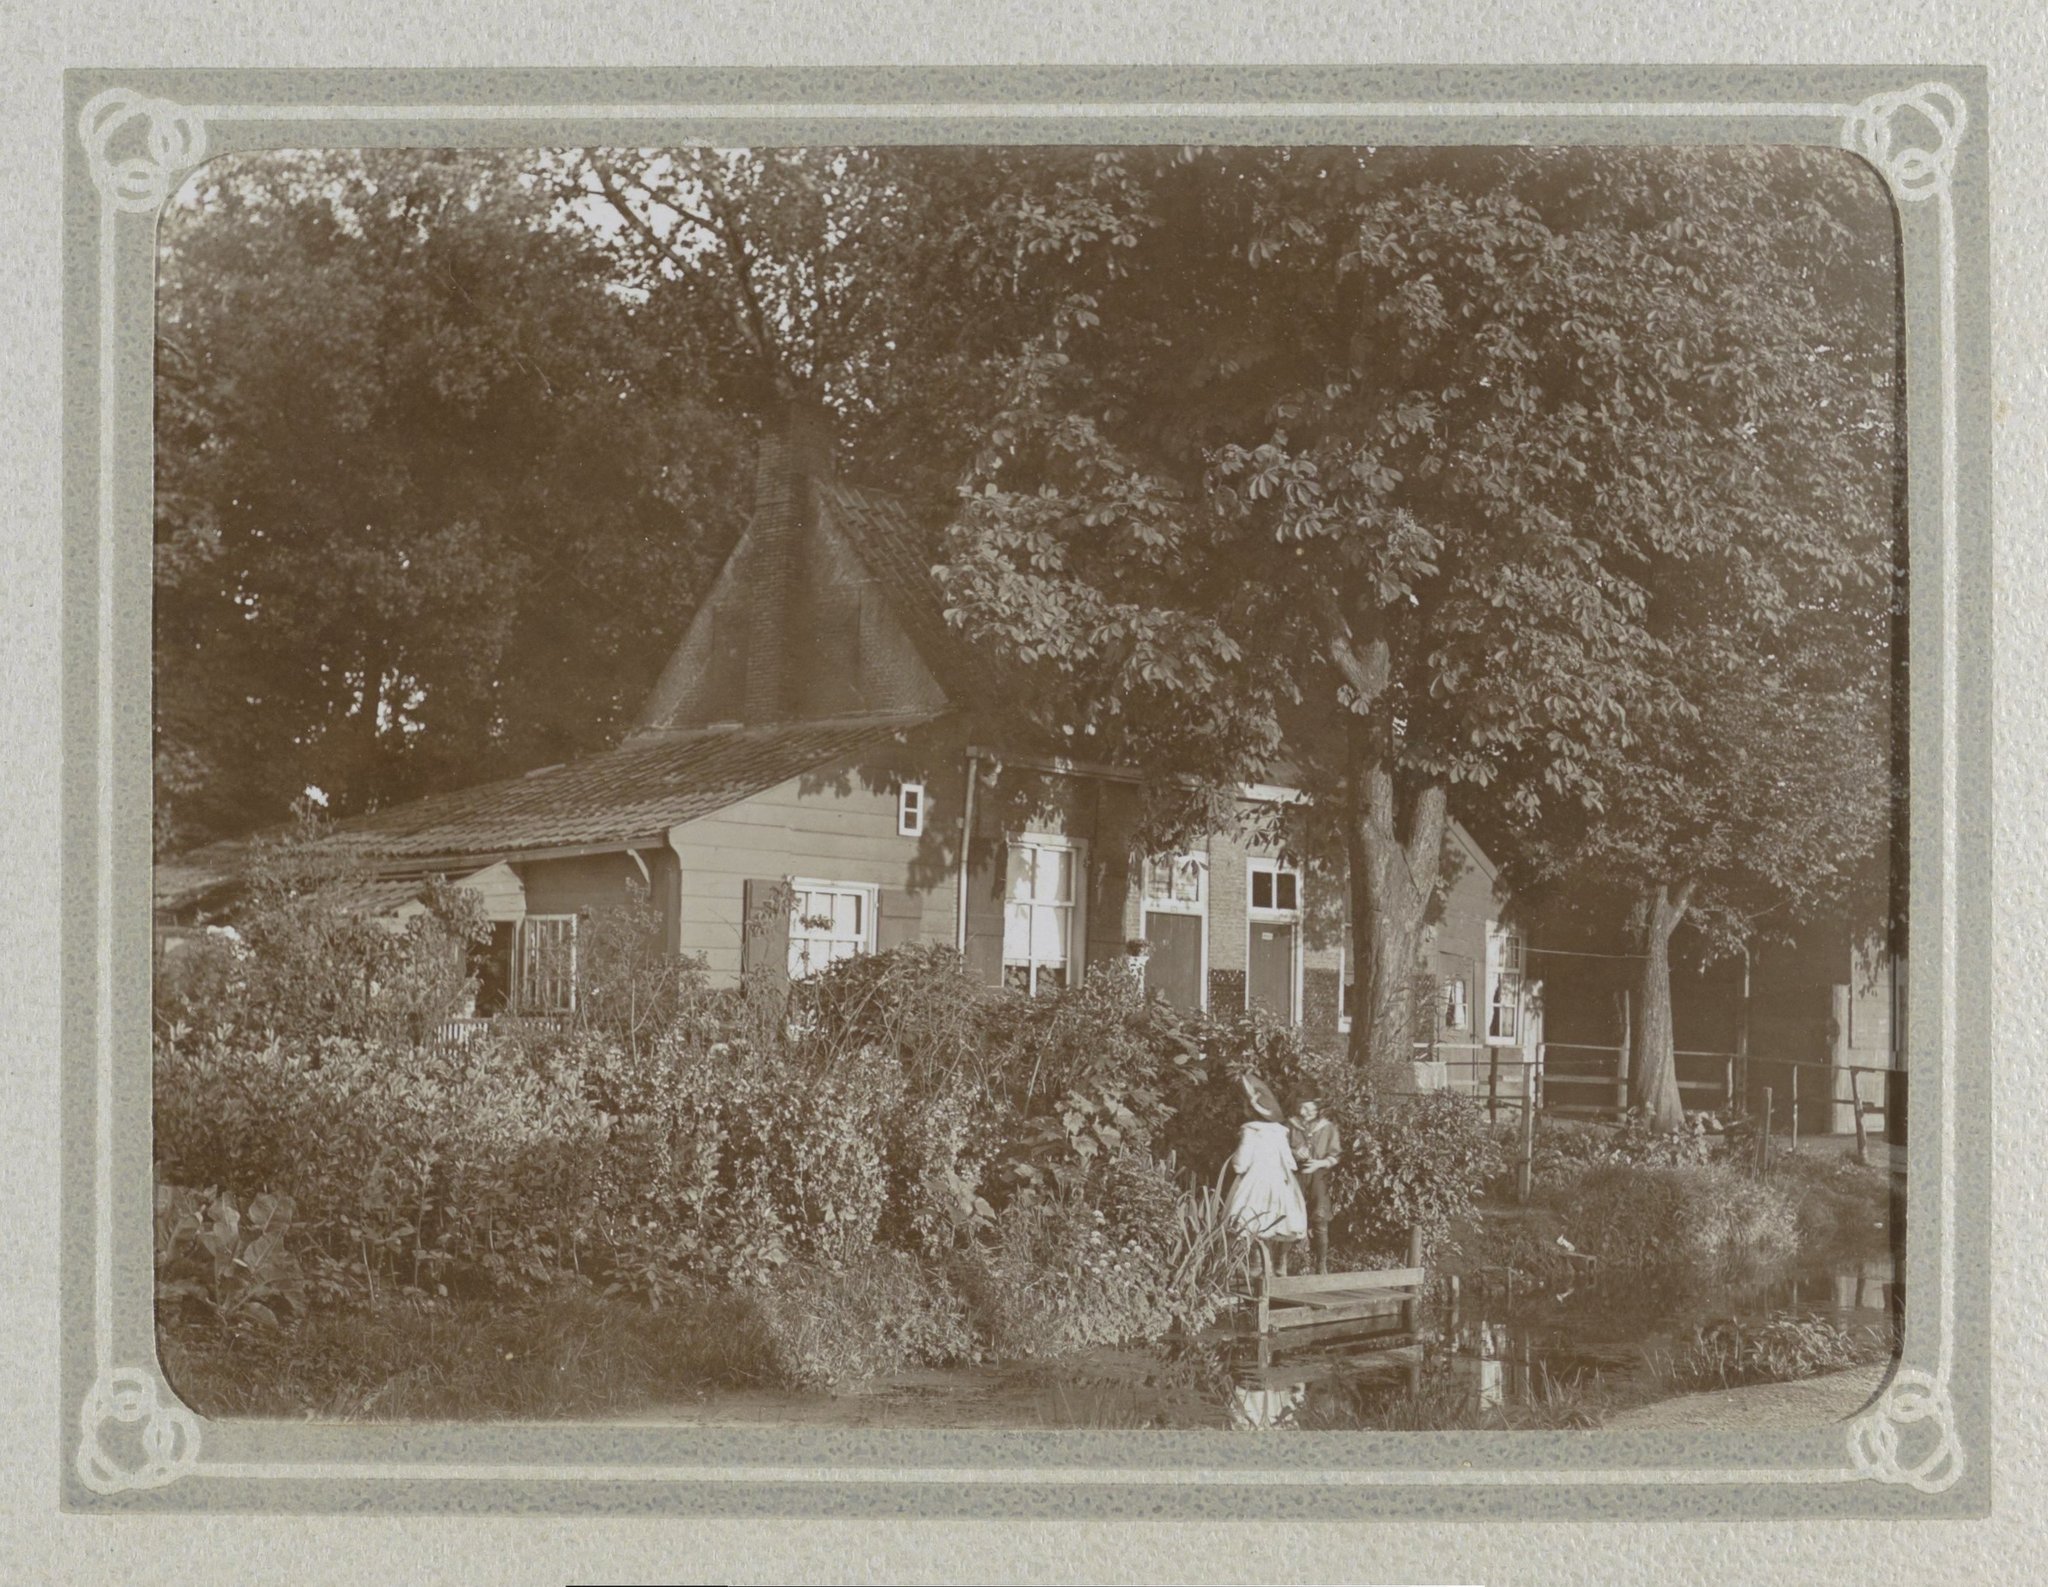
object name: photograph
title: Huis met een schuur tussen de bomen, op de voorgrond twee kinderen bij een sloot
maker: folkert idzes de jong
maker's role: architect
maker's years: 1877-1929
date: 1905-1907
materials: photographic support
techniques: collodion silver print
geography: netherlands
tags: rural housing, e.g. country-house, villa, cottage, shed, historical persons not known by name, netherlands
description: Onderdeel van Topografisch album van Nederlandse dorpen en steden 1905.